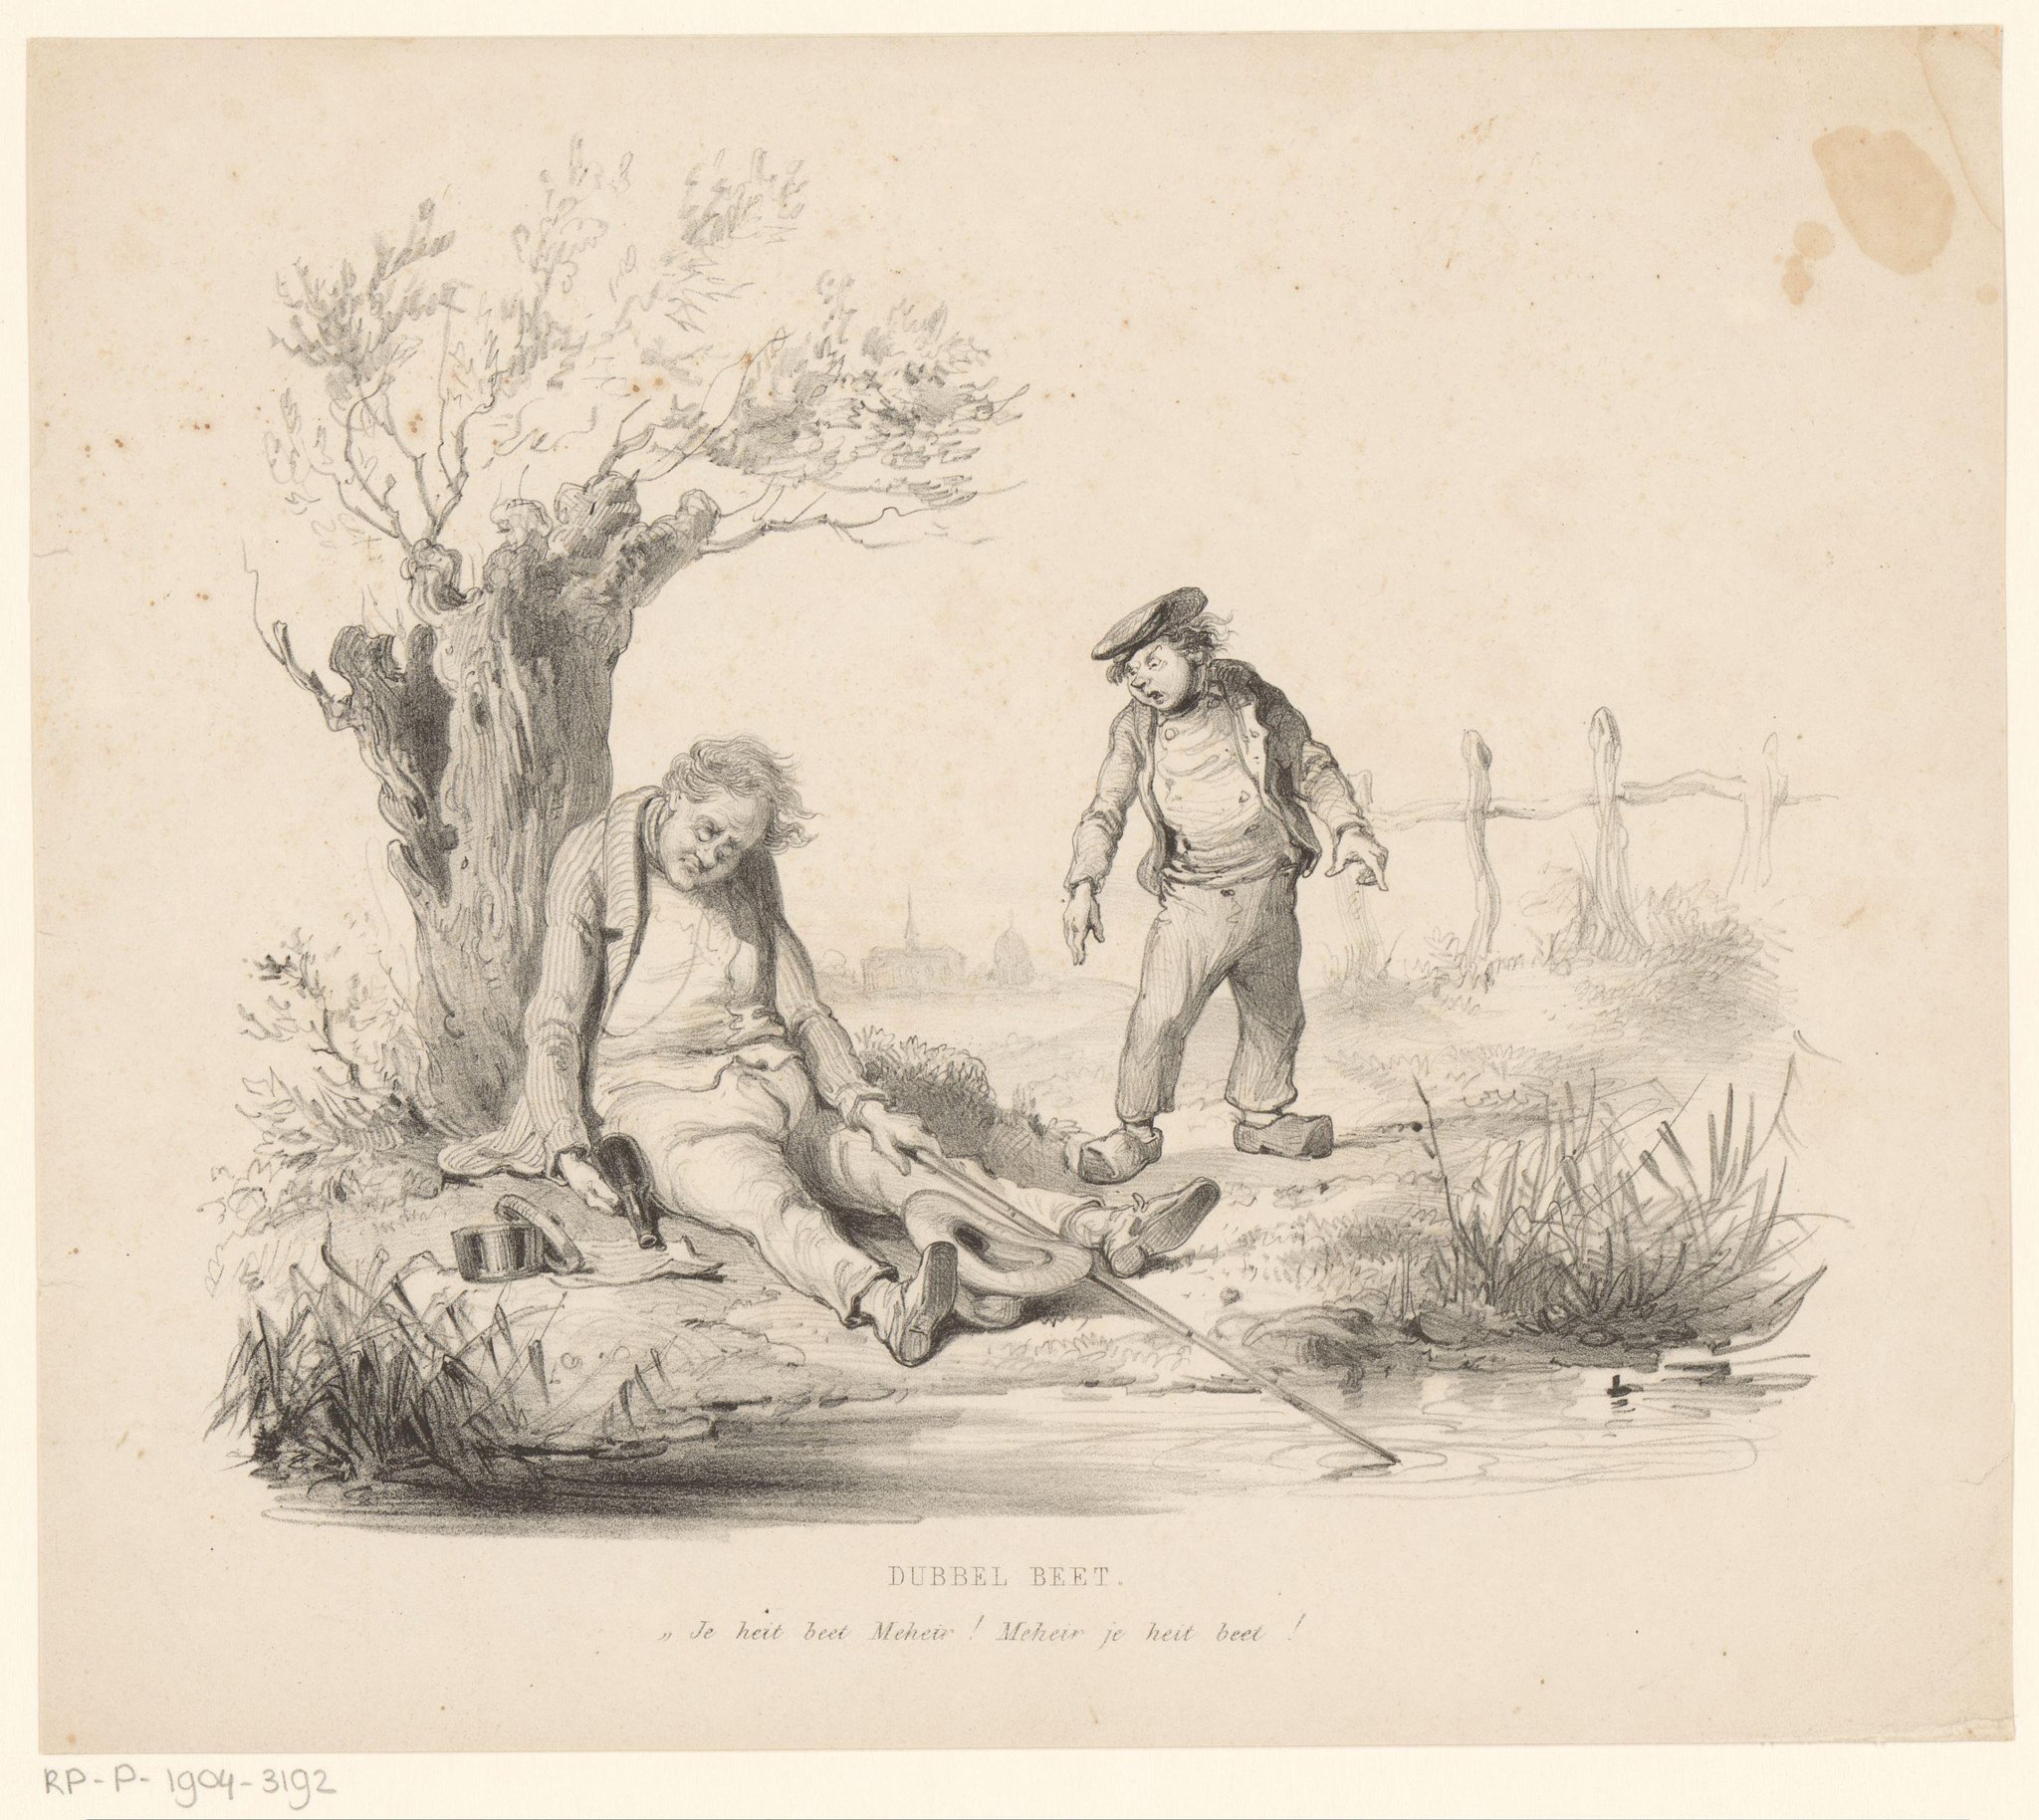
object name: print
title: Slapende man met hengel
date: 1832-1897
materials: paper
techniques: lithograph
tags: fishing (sports), sleeping; unconsciousness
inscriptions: collector's mark: Lugt 2228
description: Een man zit al slapend tegen een boom met een hengel in zijn hand. Naast hem ligt een lege fles. Een man wijst hem dat hij beet heeft.